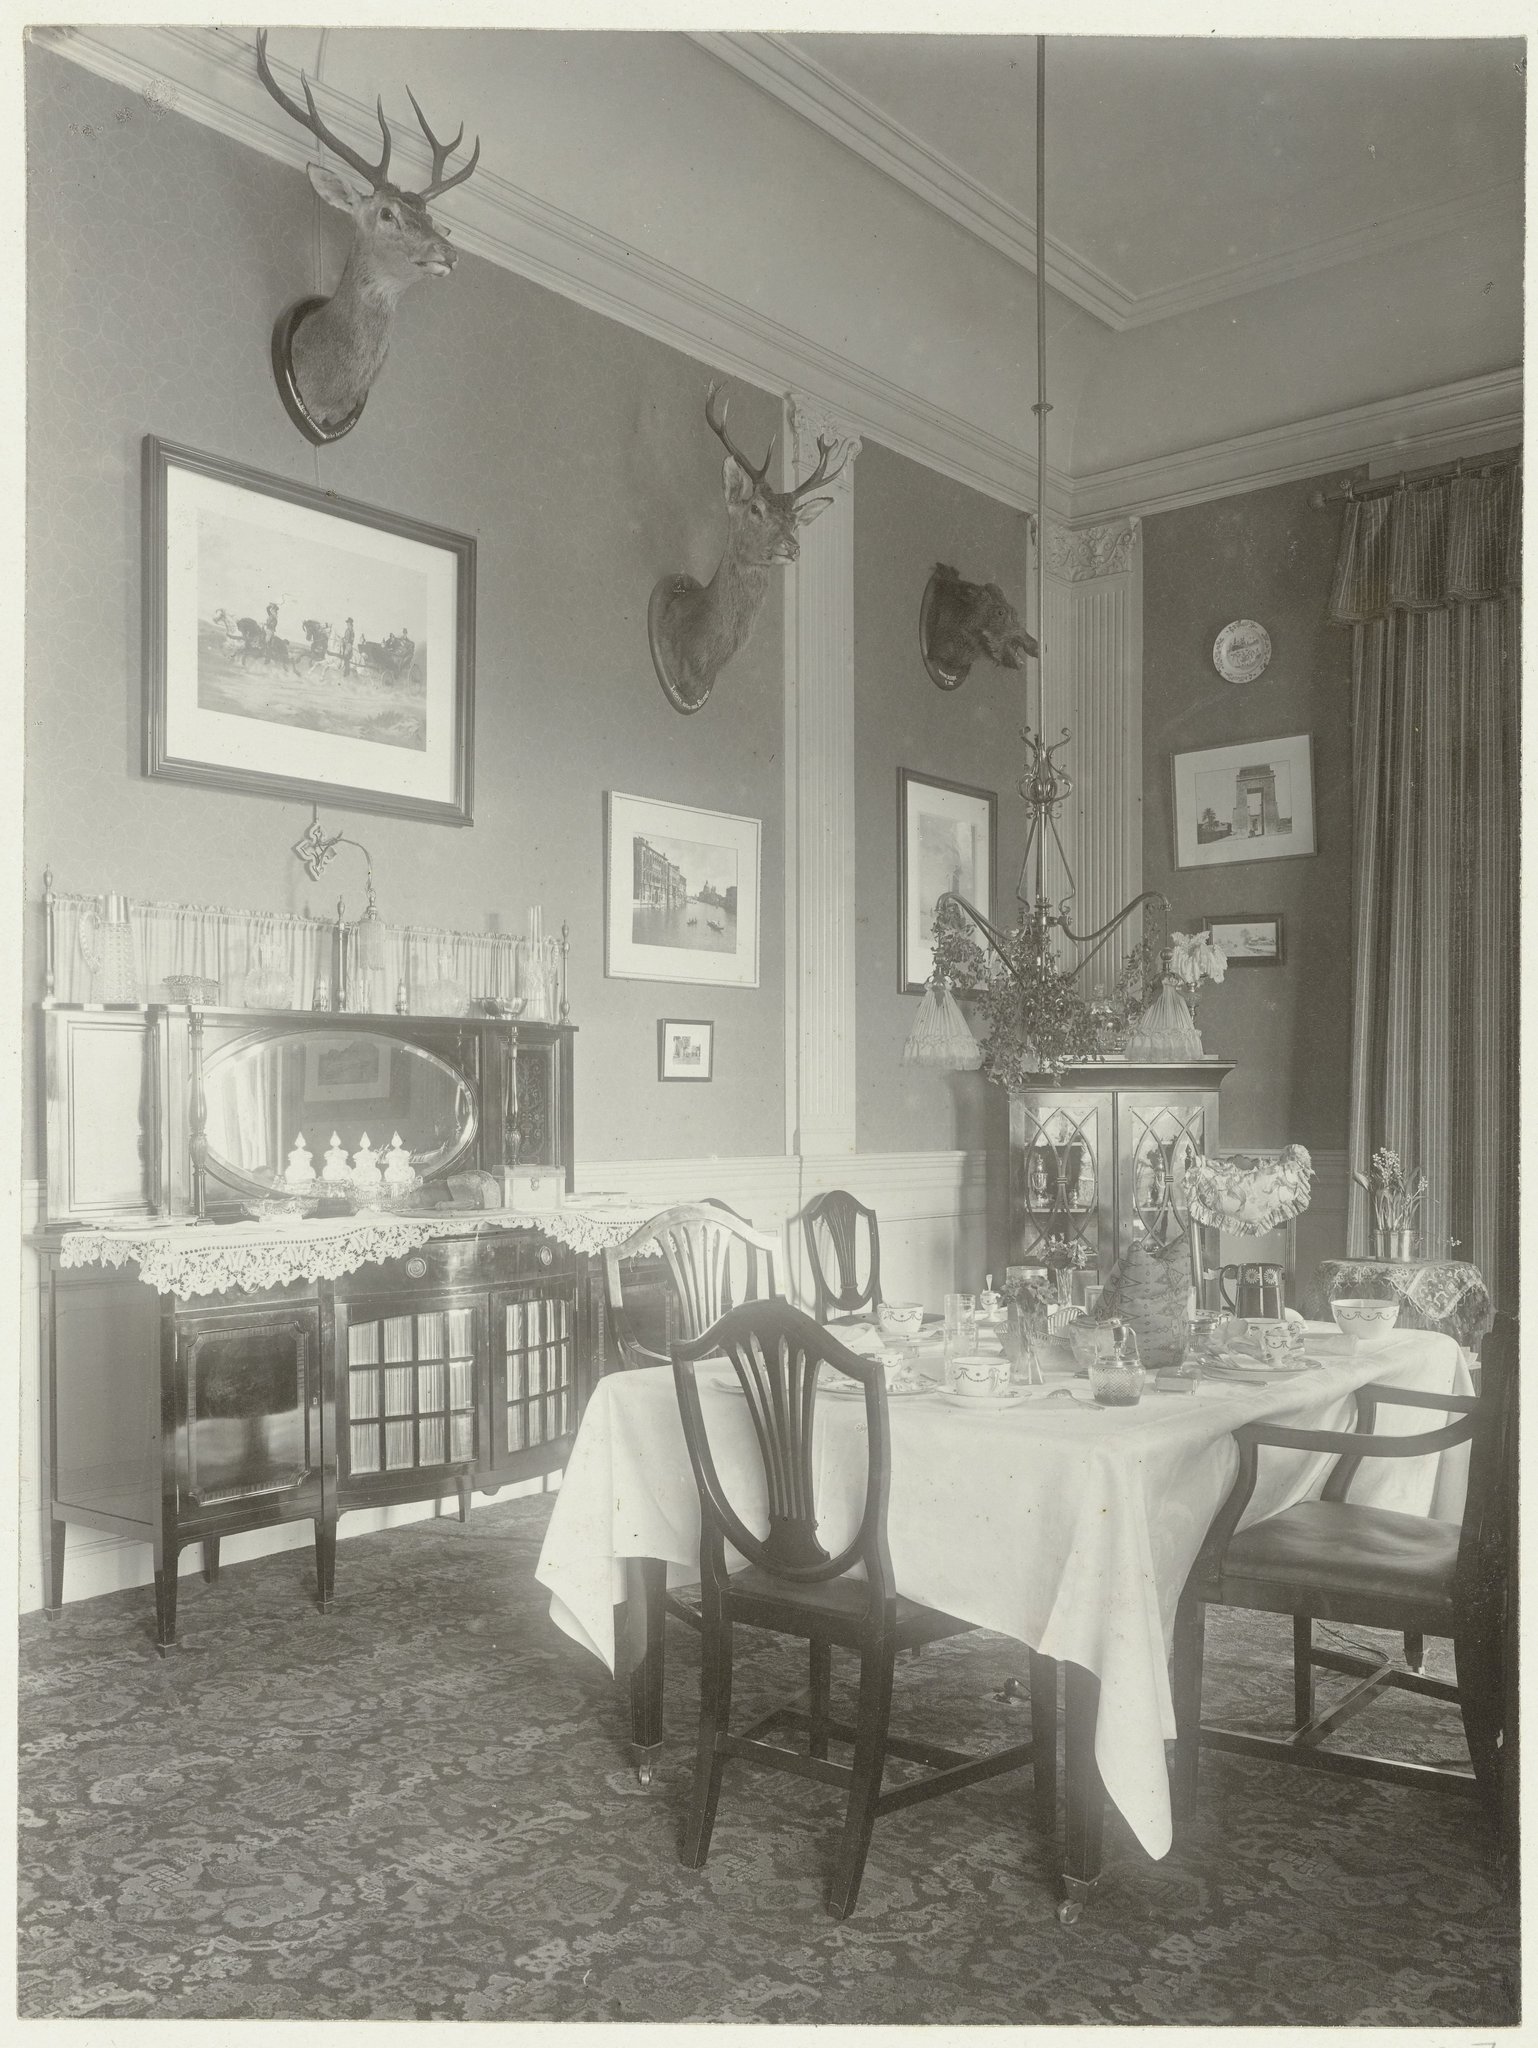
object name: photograph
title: Kamer van landgoed De Wildbaan, Driebergen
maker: henry pauw van wieldrecht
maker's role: fotograaf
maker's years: 1863-1912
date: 1903-1907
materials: paper, photographic support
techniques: gelatin silver print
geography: netherlands